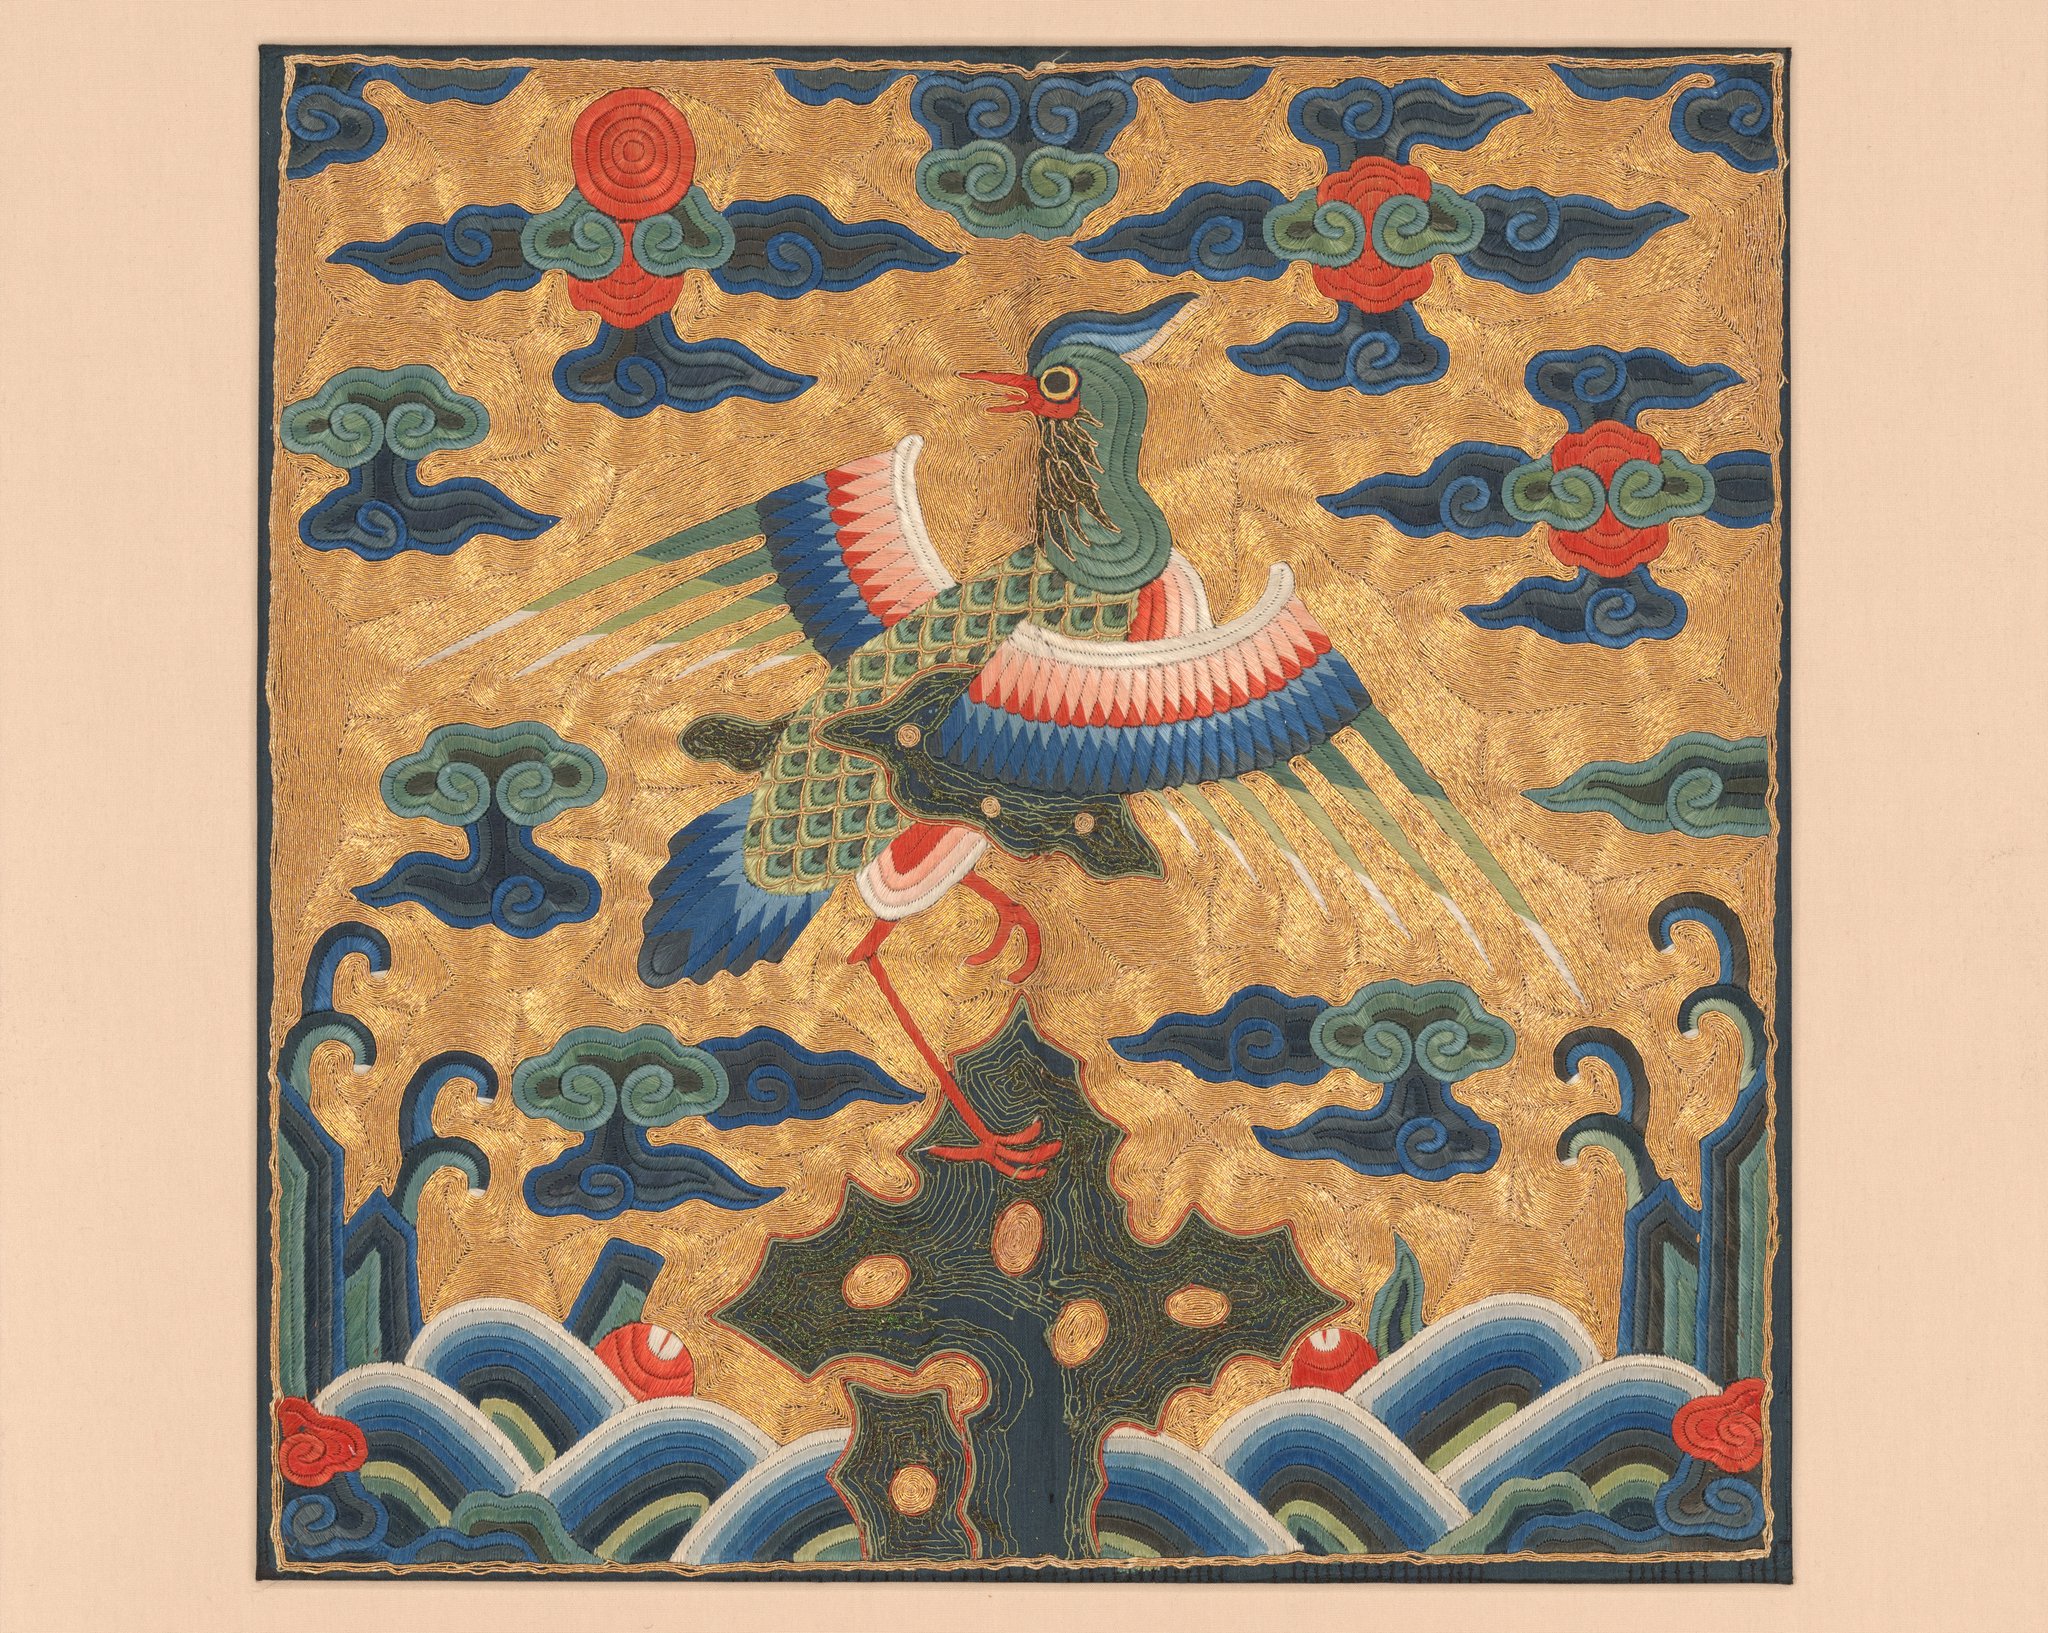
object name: rank badge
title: Rank Badge with Mandarin Duck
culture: chinese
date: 1701-1800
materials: metal thread, silk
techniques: embroidery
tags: ducks